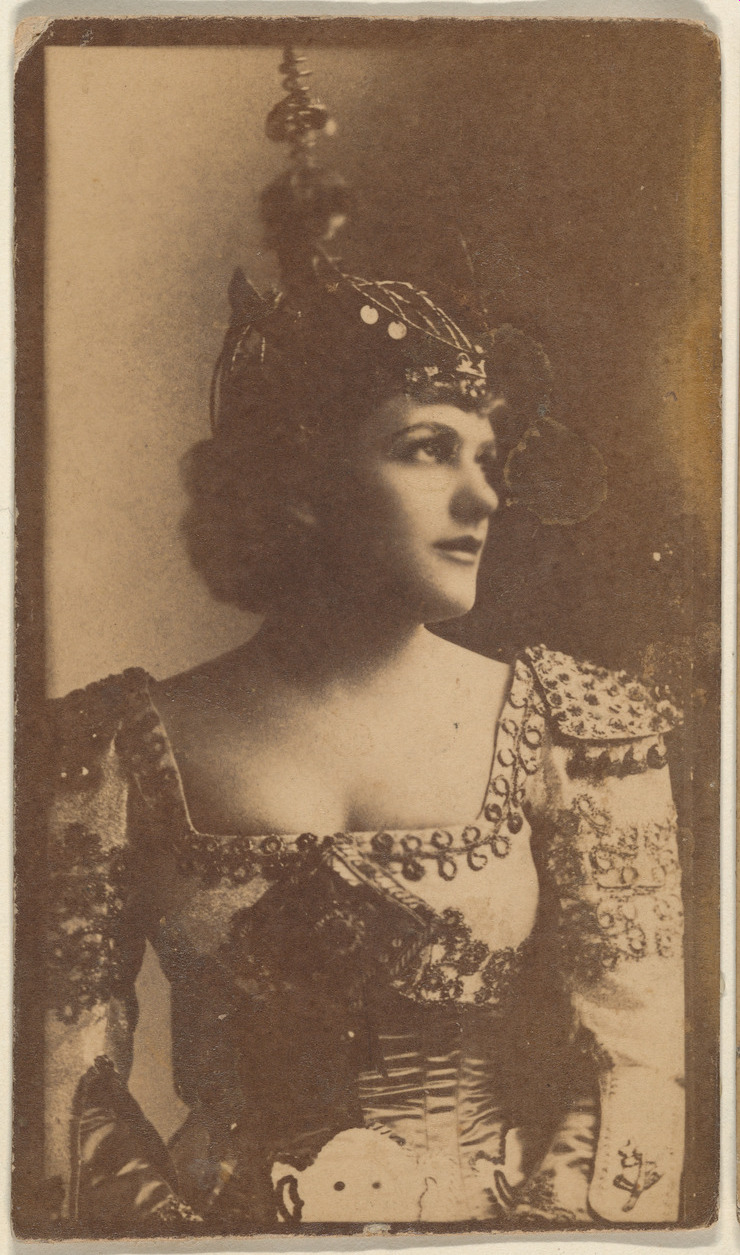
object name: photograph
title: Actress wearing costume with pointed hat, from the Actresses series (N668)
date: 1888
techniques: albumen silver print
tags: portraits,women,actresses